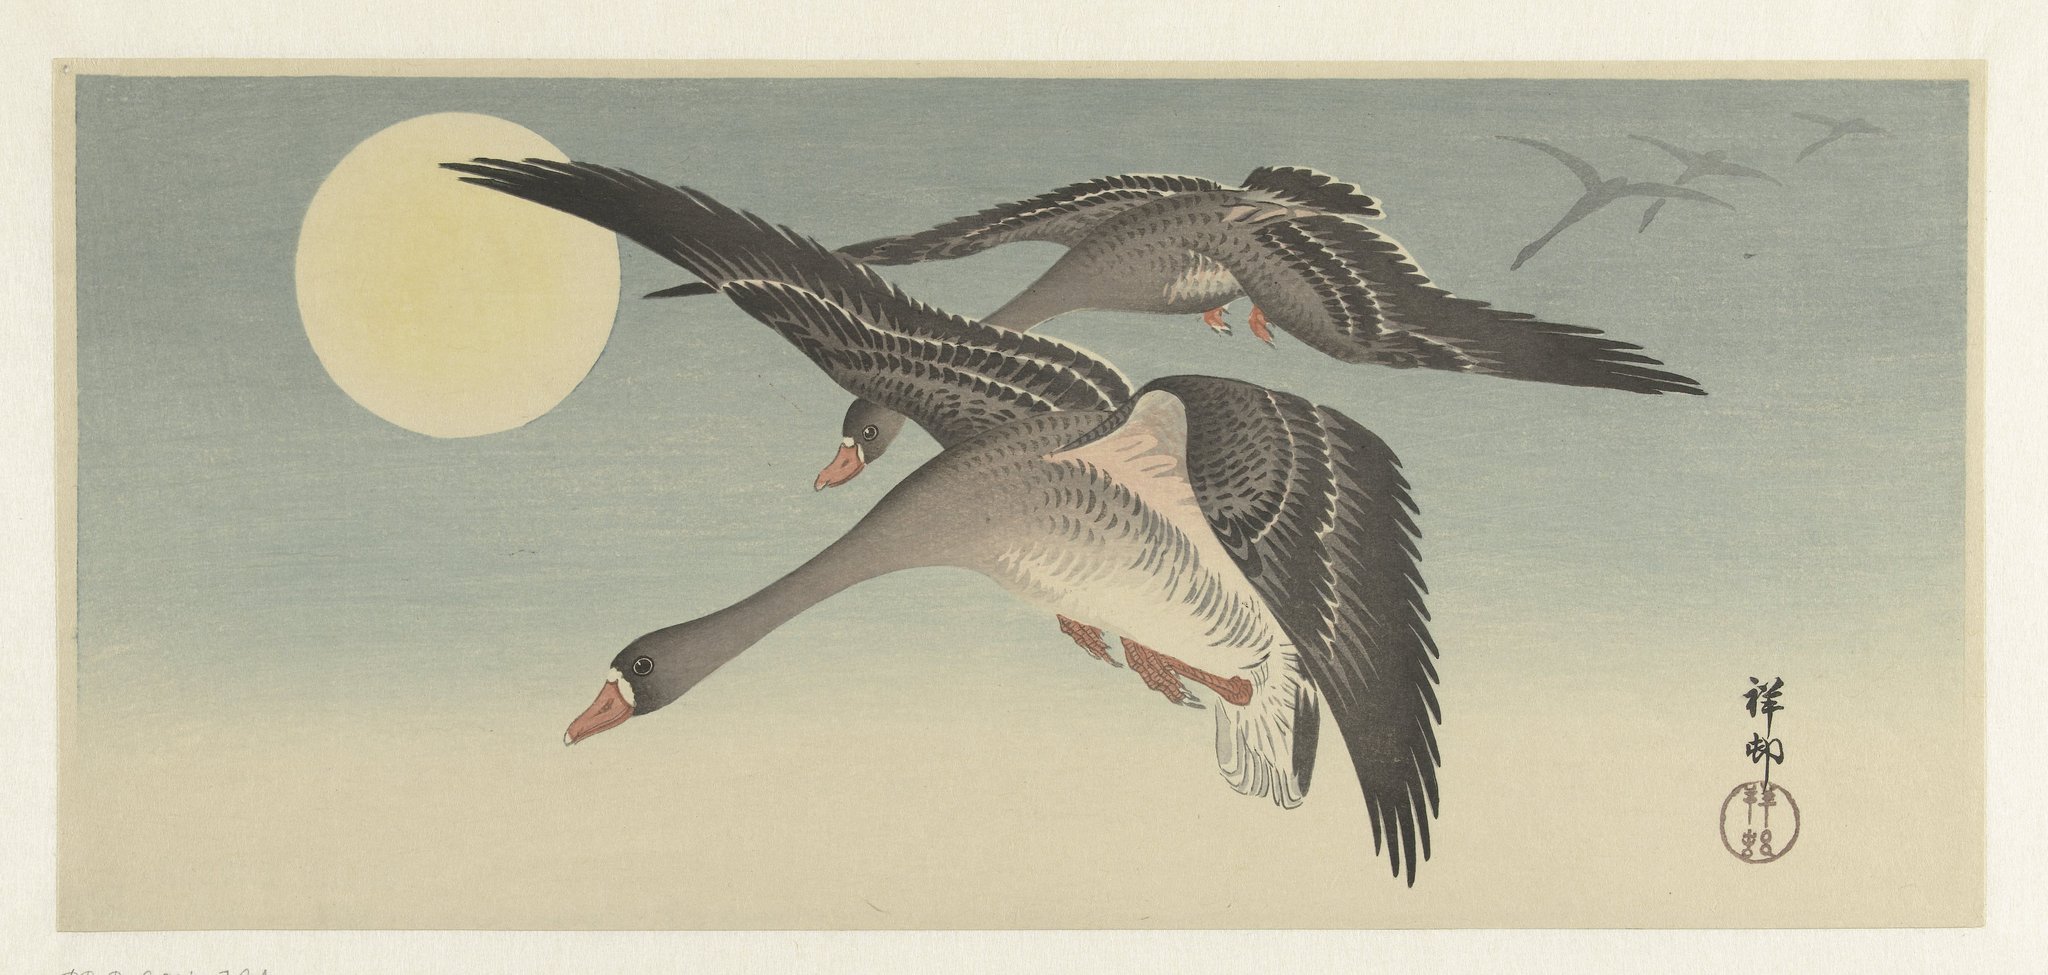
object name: print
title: Ganzen bij volle maan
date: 1925-1936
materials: paper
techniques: woodcut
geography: tokyo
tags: full moon, water-birds: goose, flying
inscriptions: collector's mark: Lugt 2228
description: Twee ganzen in vlucht bij volle maan. In de achtergrond de silhouetten van nog drie ganzen.